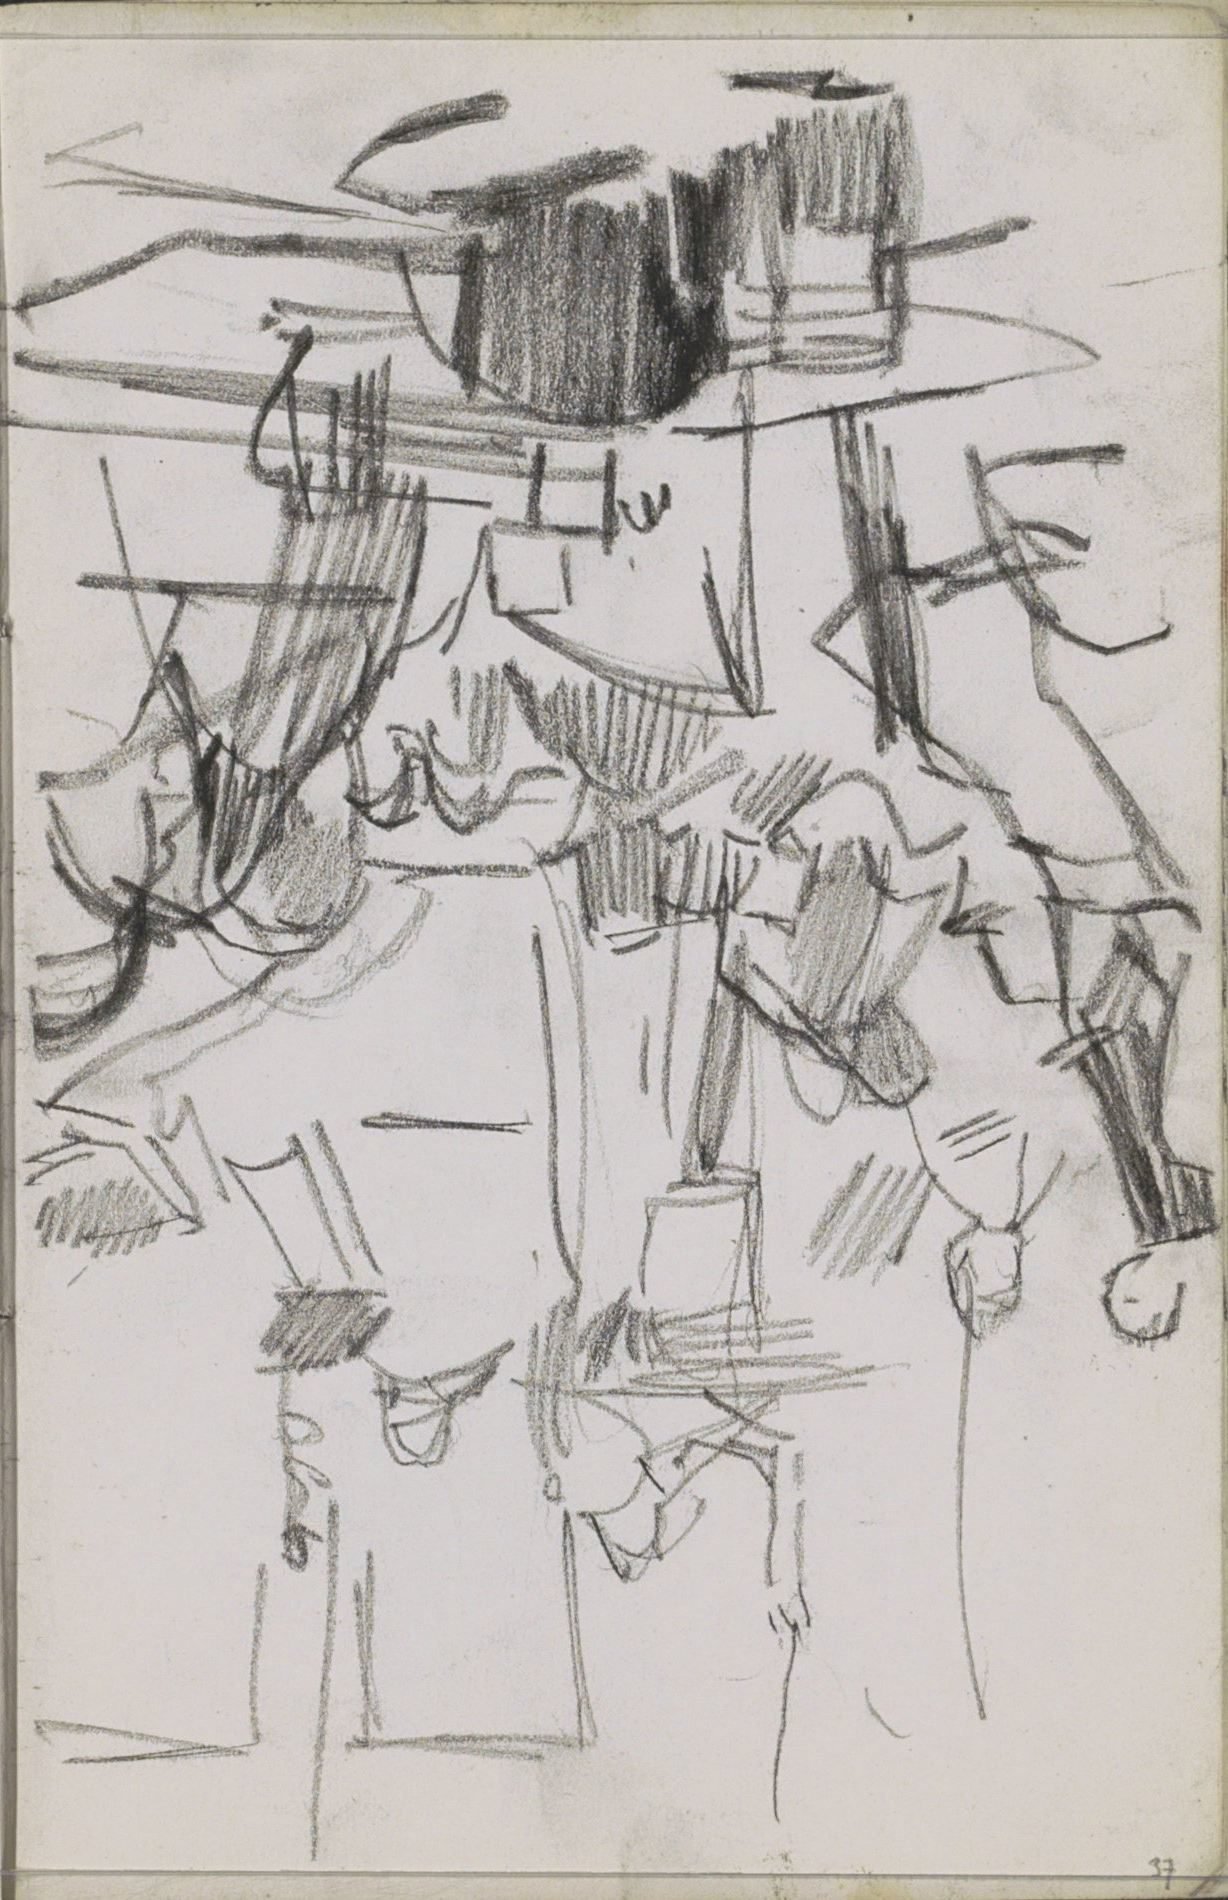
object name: sketchbook leaf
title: Figuren aan tafels, mogelijk in een café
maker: isaac israels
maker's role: draughtsman, painter, print maker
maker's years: 1865-1934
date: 1875-1934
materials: chalk, paper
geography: amsterdam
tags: inn, coffee-house, public house, etc., the audience ~ art performance, female singer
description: Ze luisteren mogelijk naar een zangeres. Pagina 37 uit schetsboek XXIX met 44 pagina's.